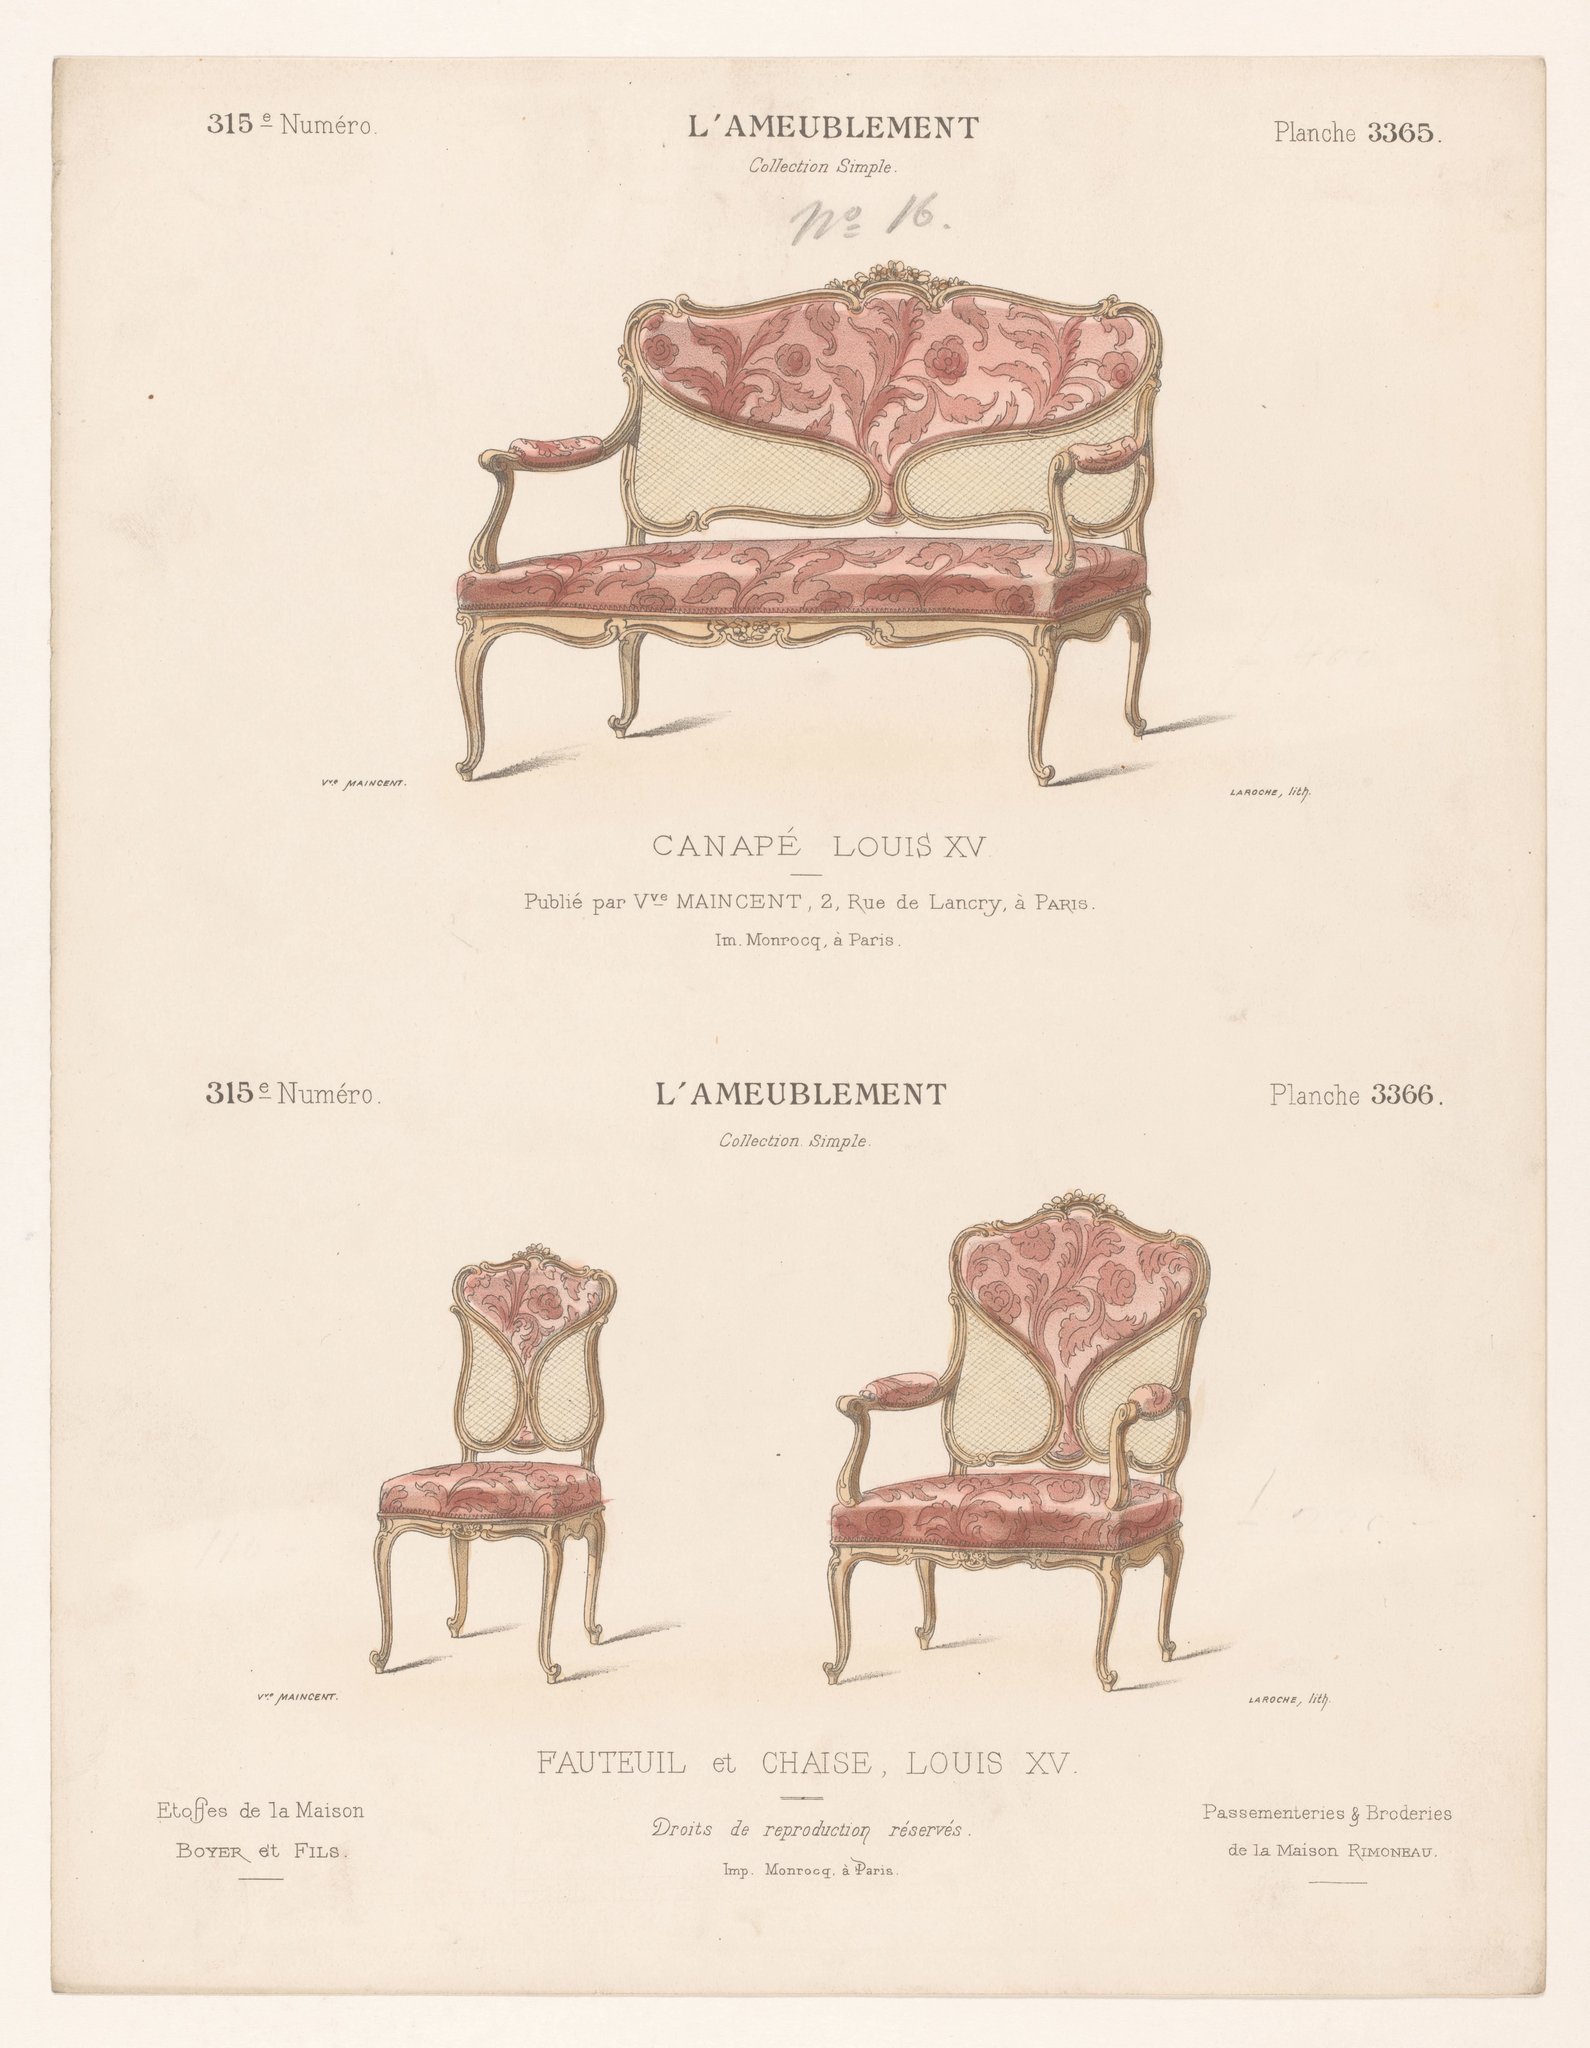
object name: print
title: Canapé, fauteuil en stoel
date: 1895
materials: paper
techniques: hand coloring, lithograph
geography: paris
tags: seating furniture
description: Een canapé, fauteuil en een stoel in de Lodewijk XV-stijl. Prent uit 315e nummer (livraison).